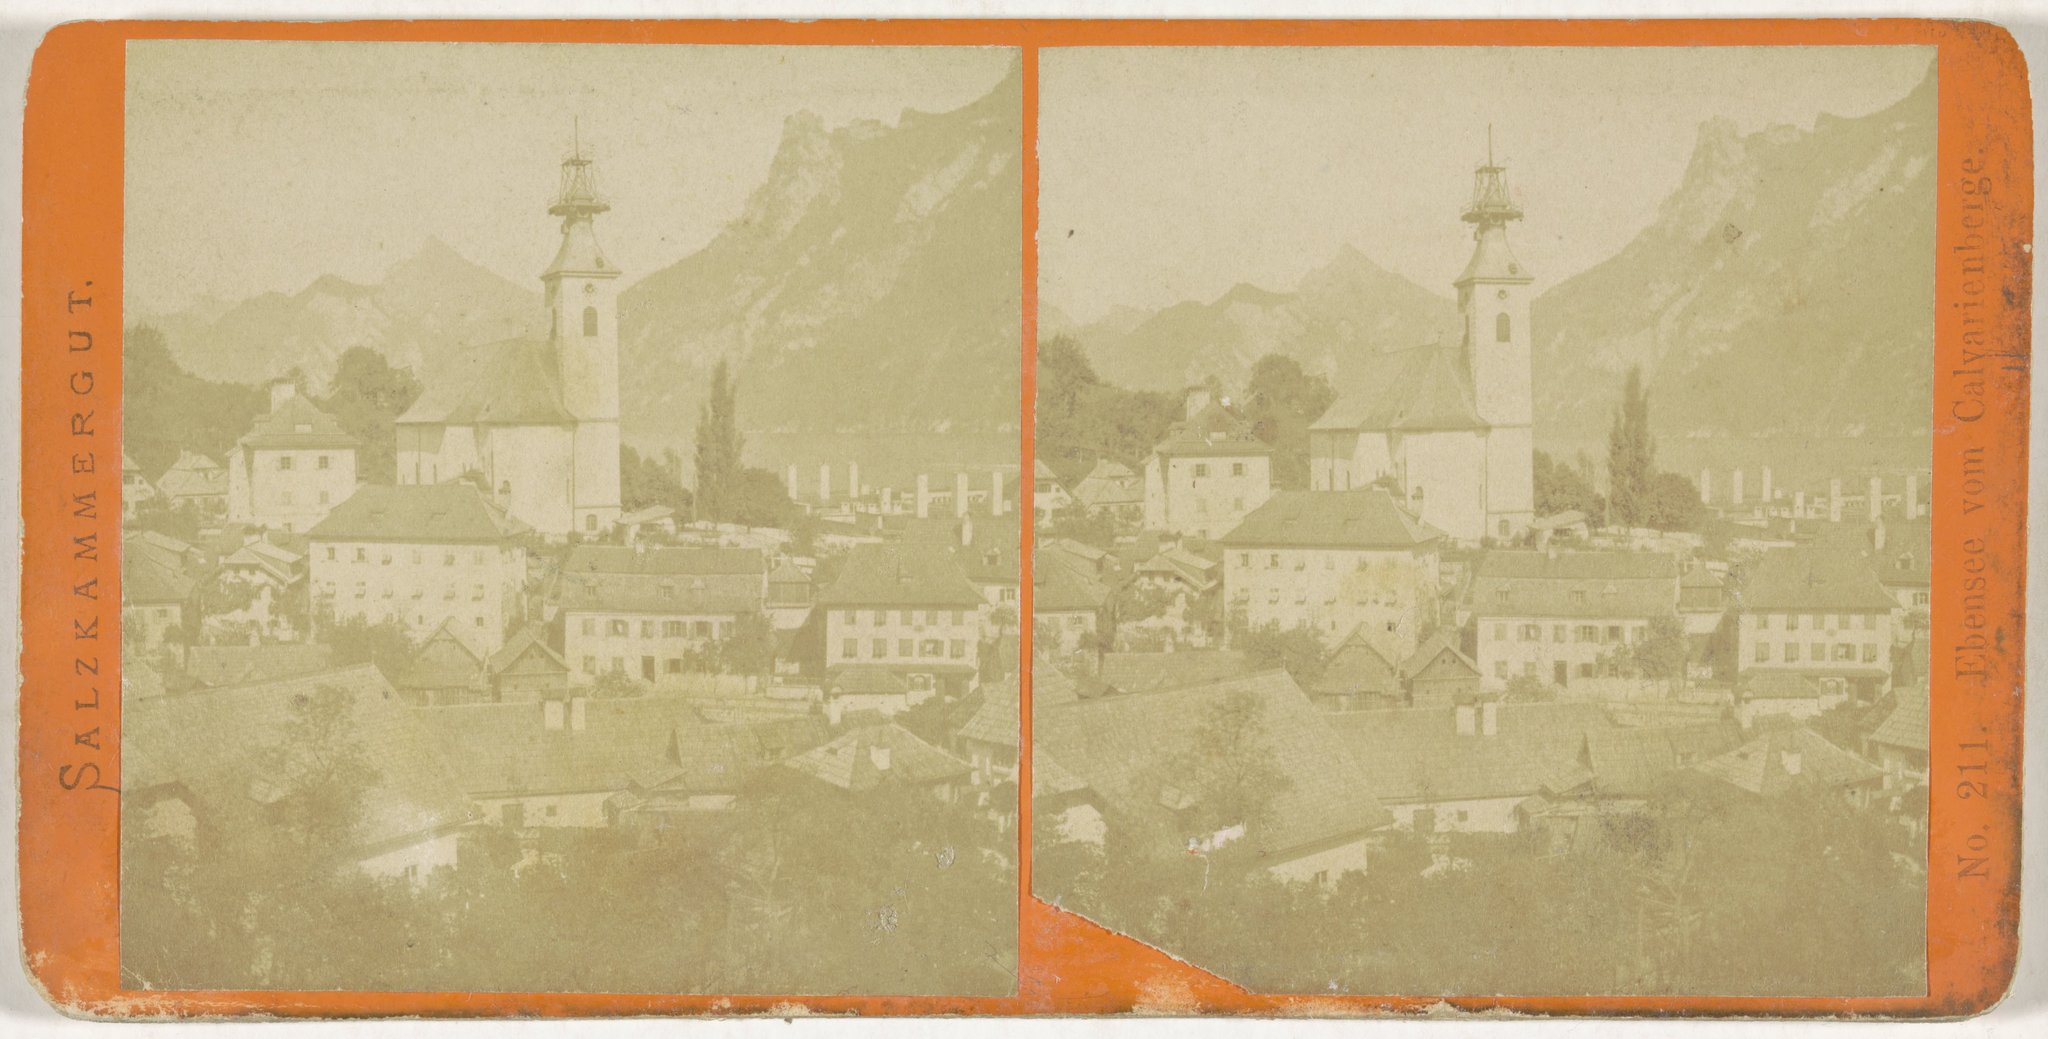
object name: stereograph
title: Ebensee vom Calvarienberge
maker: Anonymous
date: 1862-1880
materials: cardboard, paper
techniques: albumen print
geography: ebensee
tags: church (exterior), mountains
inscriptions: number: ‘No. 211’